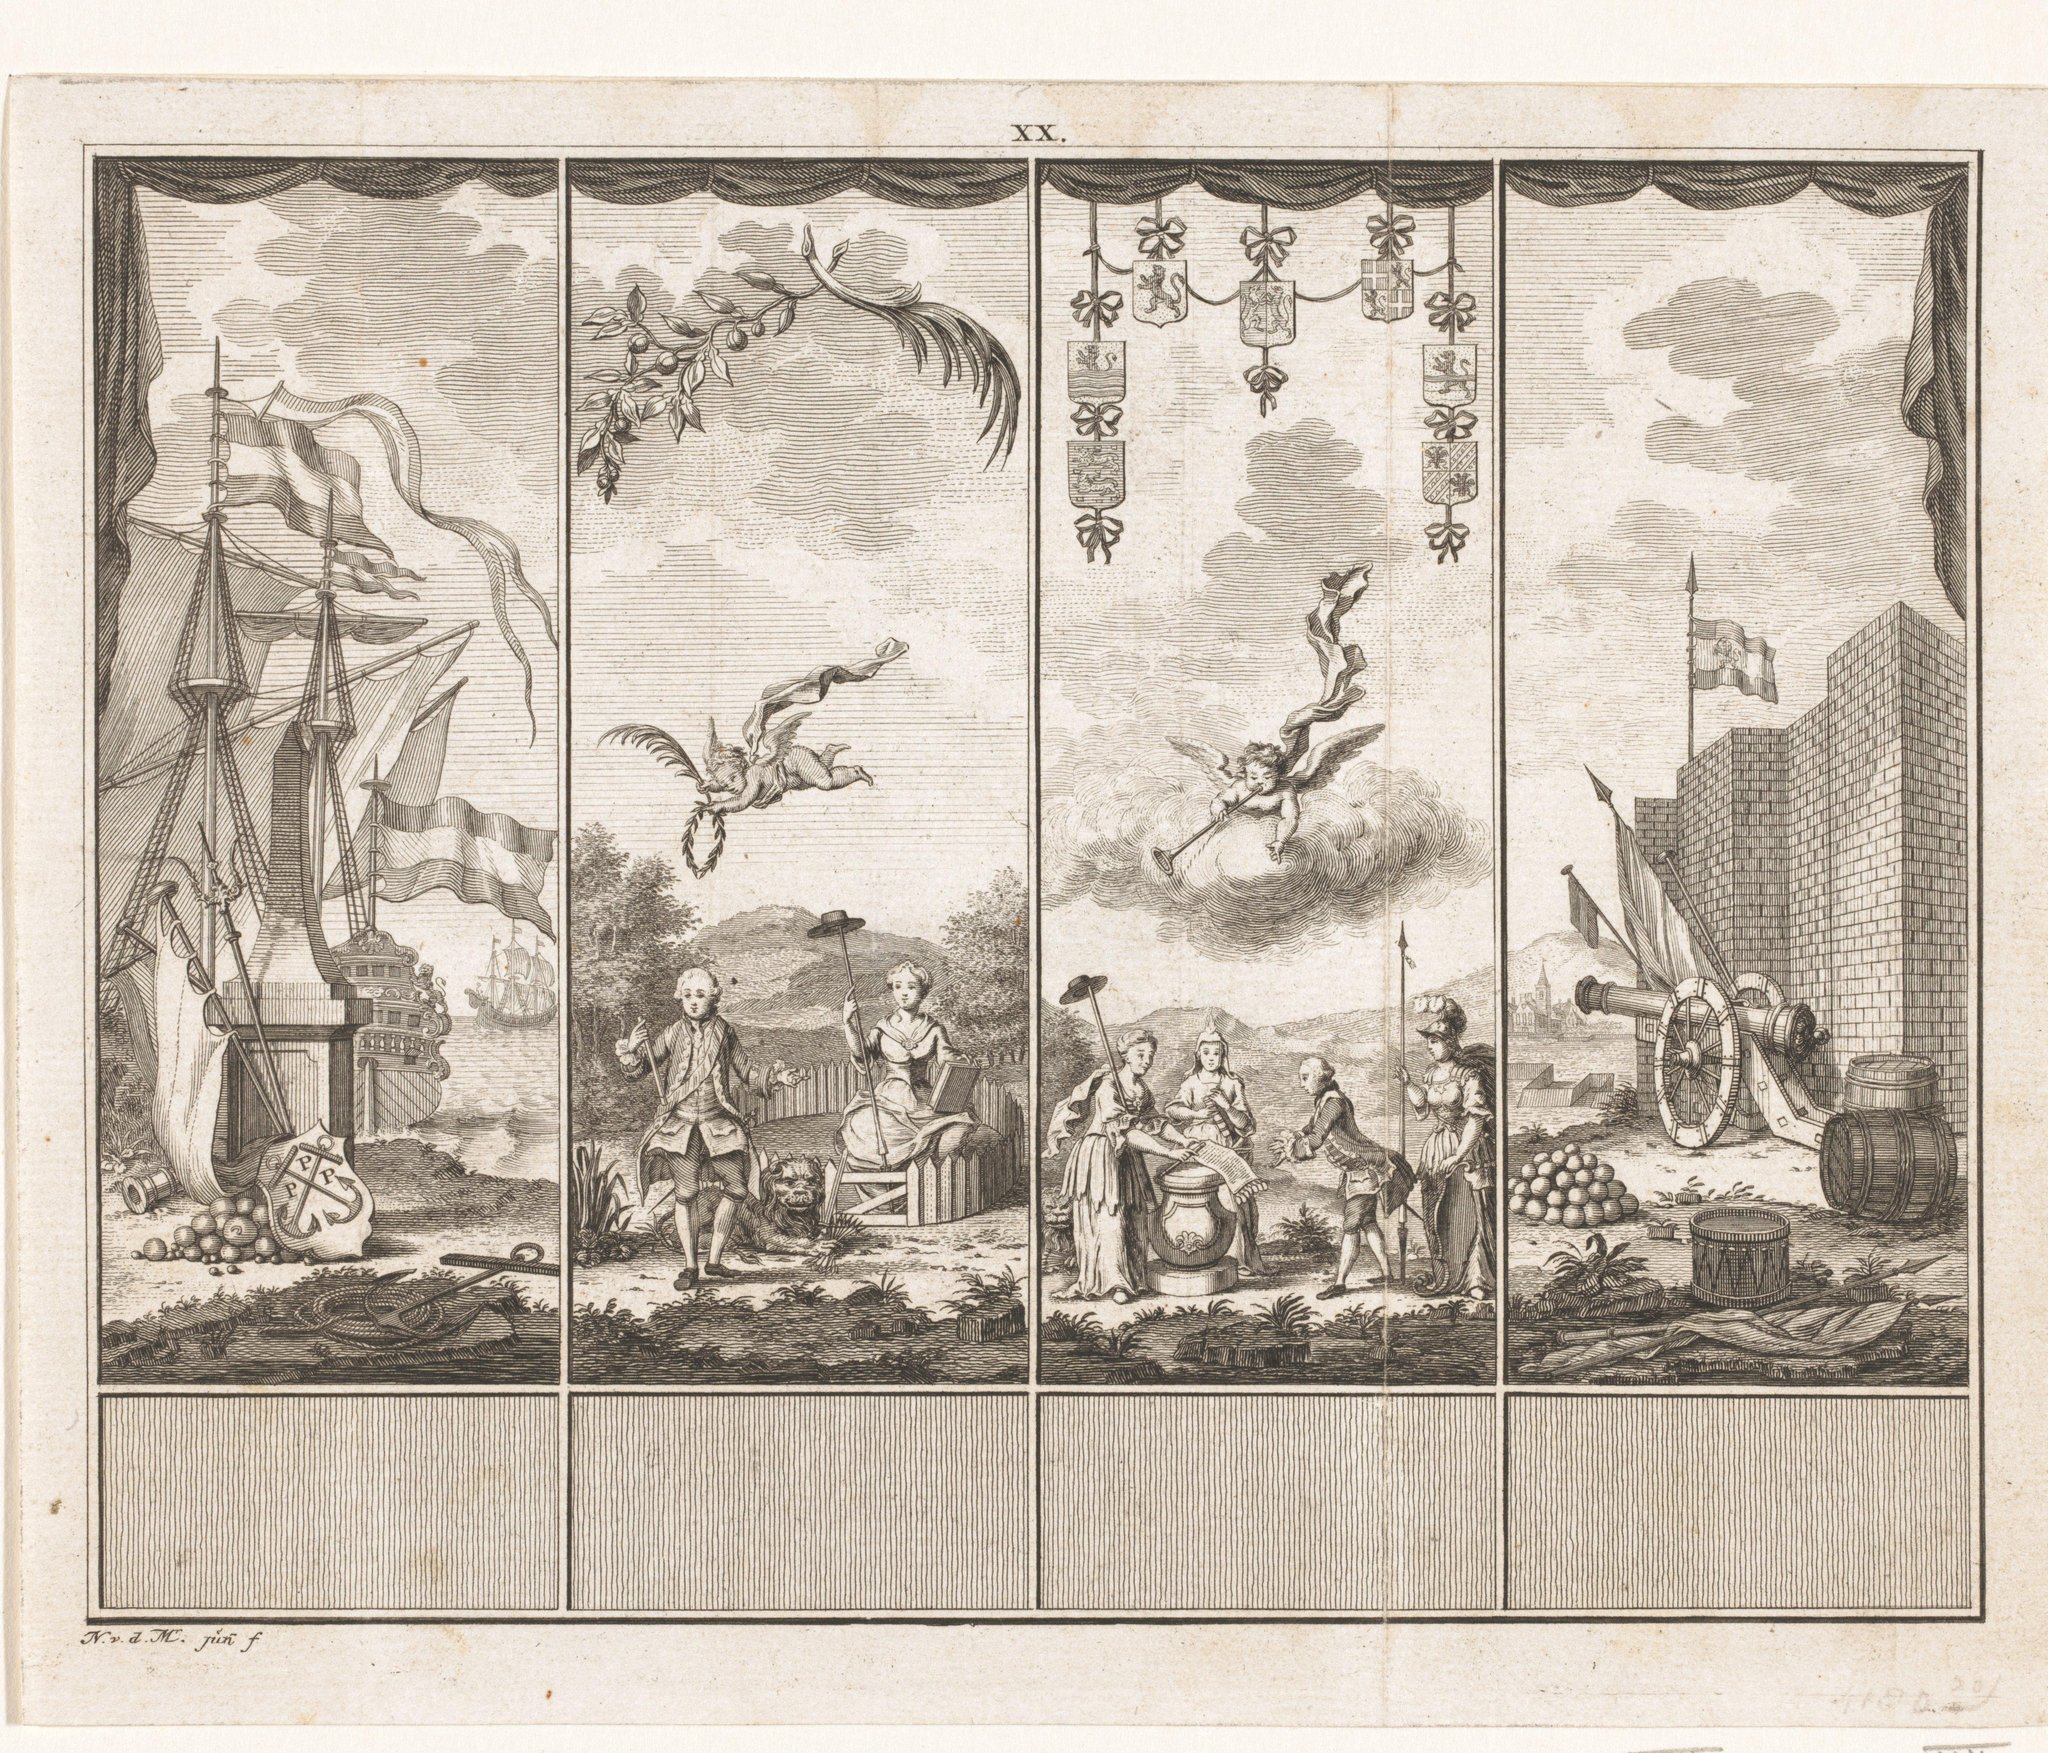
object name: print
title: Decoraties bij het huis van burgemeester R. Blok te Hoorn, 1766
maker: noach van der meer (ii)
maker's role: draughtsman, print maker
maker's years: 1741-1822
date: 1774-1776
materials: paper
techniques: engraving, etching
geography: northern netherlands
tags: the hague, william v (prince of orange), public festivities (+ festive decoration ~ festive activities), hoorn (north holland)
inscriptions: collector's mark: Lugt 2228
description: Gebruikt als illustratie in: Verlicht en juichend Nederland, of Vaderlandsche geschiedenissen; van het tijdstip, dat (...) den heere prinse van Oranje (...) digniteiten (...) heeft aenvaerd. Leiden: Cornelis van Hoogeveen junior, Cornelis van Leiden, 1776, p. 340/341.